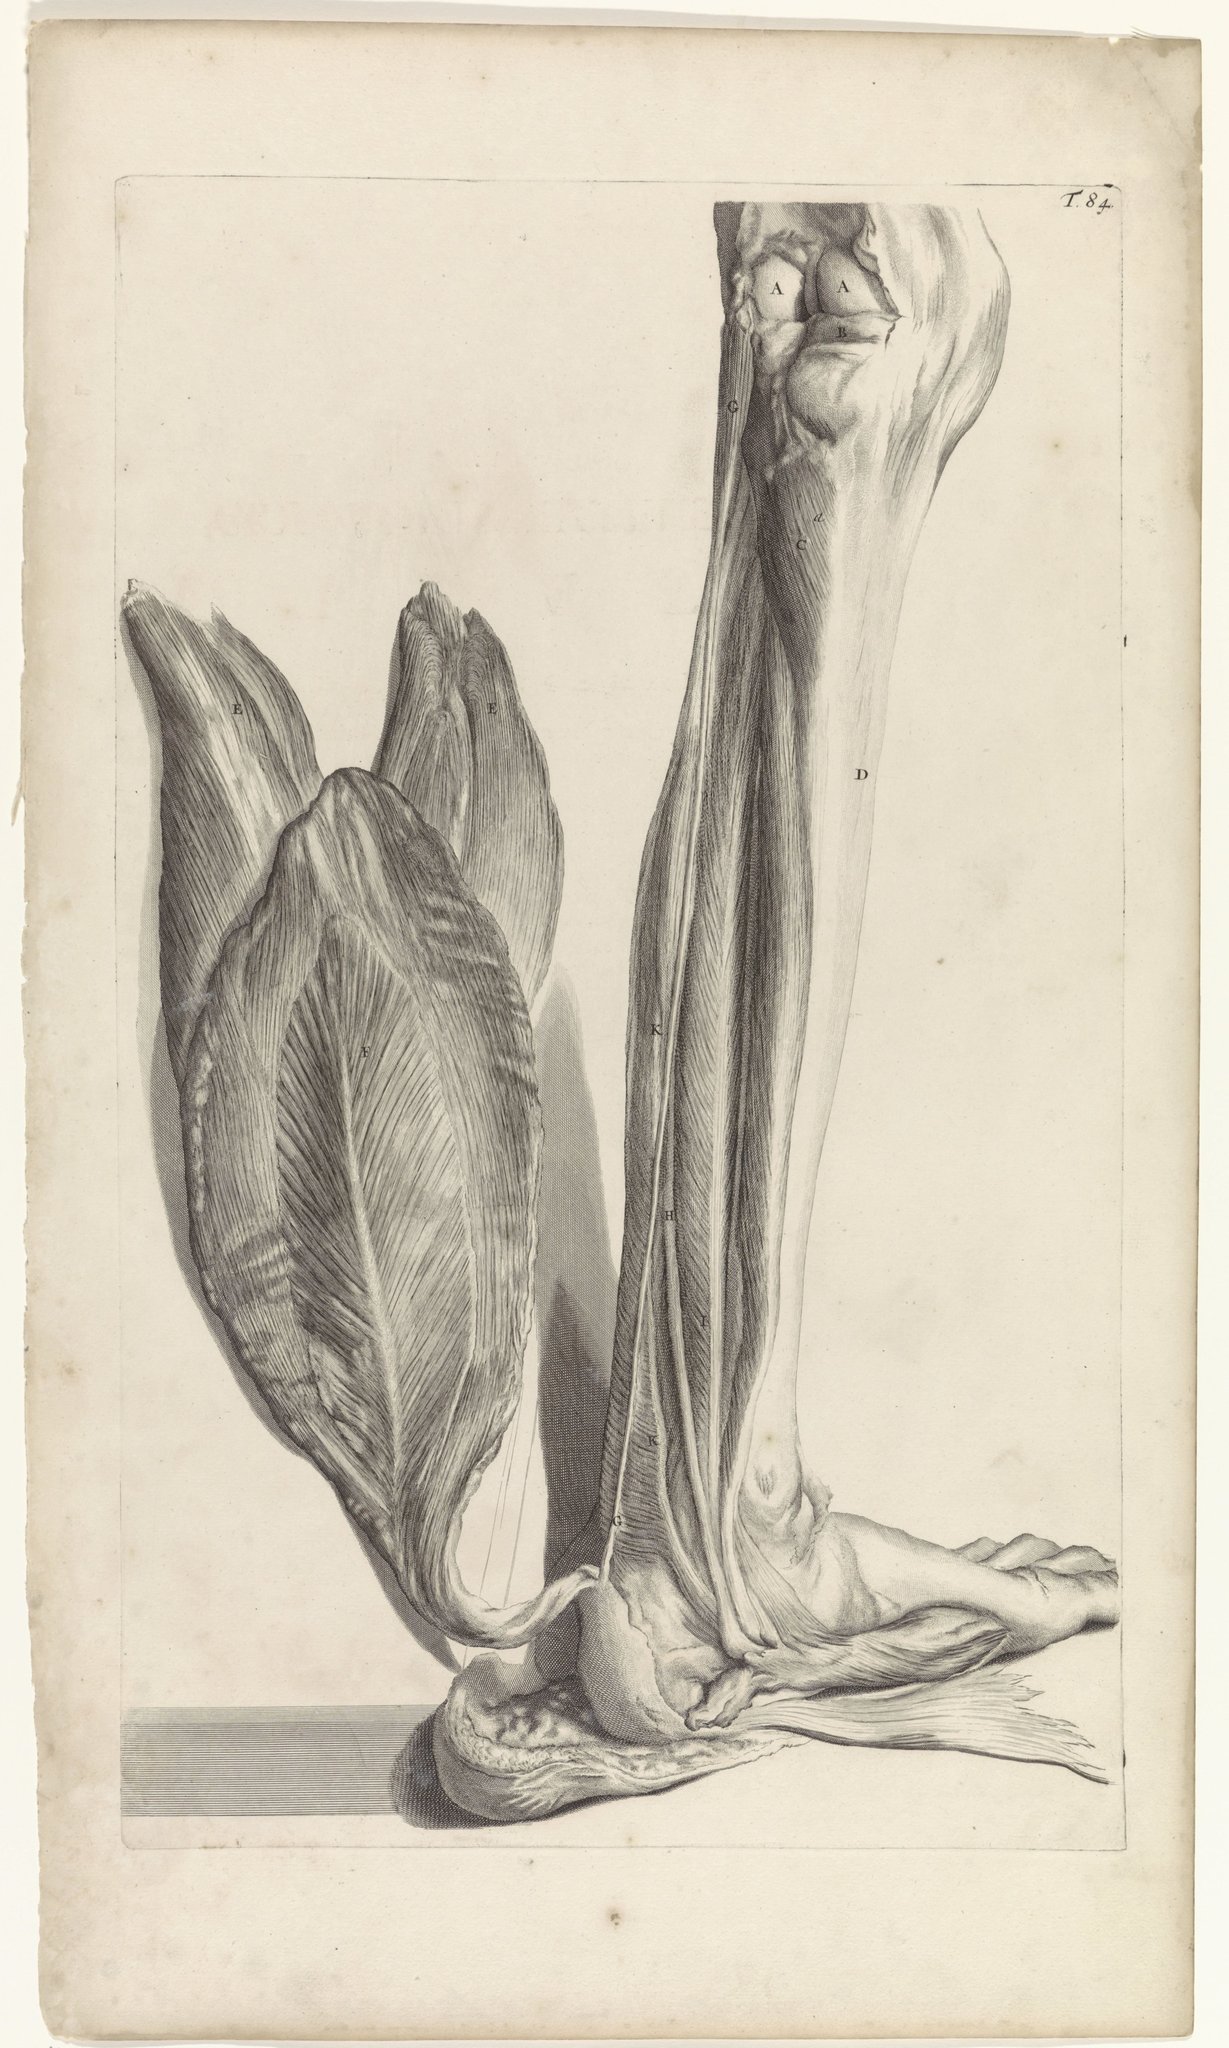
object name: print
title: Anatomische studie van de achterkant van de linkervoet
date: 1685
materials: paper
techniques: engraving, etching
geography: amsterdam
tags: lower leg, muscles, foot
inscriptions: collector's mark: Lugt 2228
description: Boekillustratie voor Bidloo, Godefridus. Anatomia humani corporis centum & quinque tabulis, per art. G. de Lairesse ad vivum delineatis, de monstrata, veterum recentiorumque inventis explicata plurimisque, hactenus non detectis, illustrata. Amsterdam: Weduwe Joannes van Someren, Hendrick Boom en erven Dirk Boom, 1685.